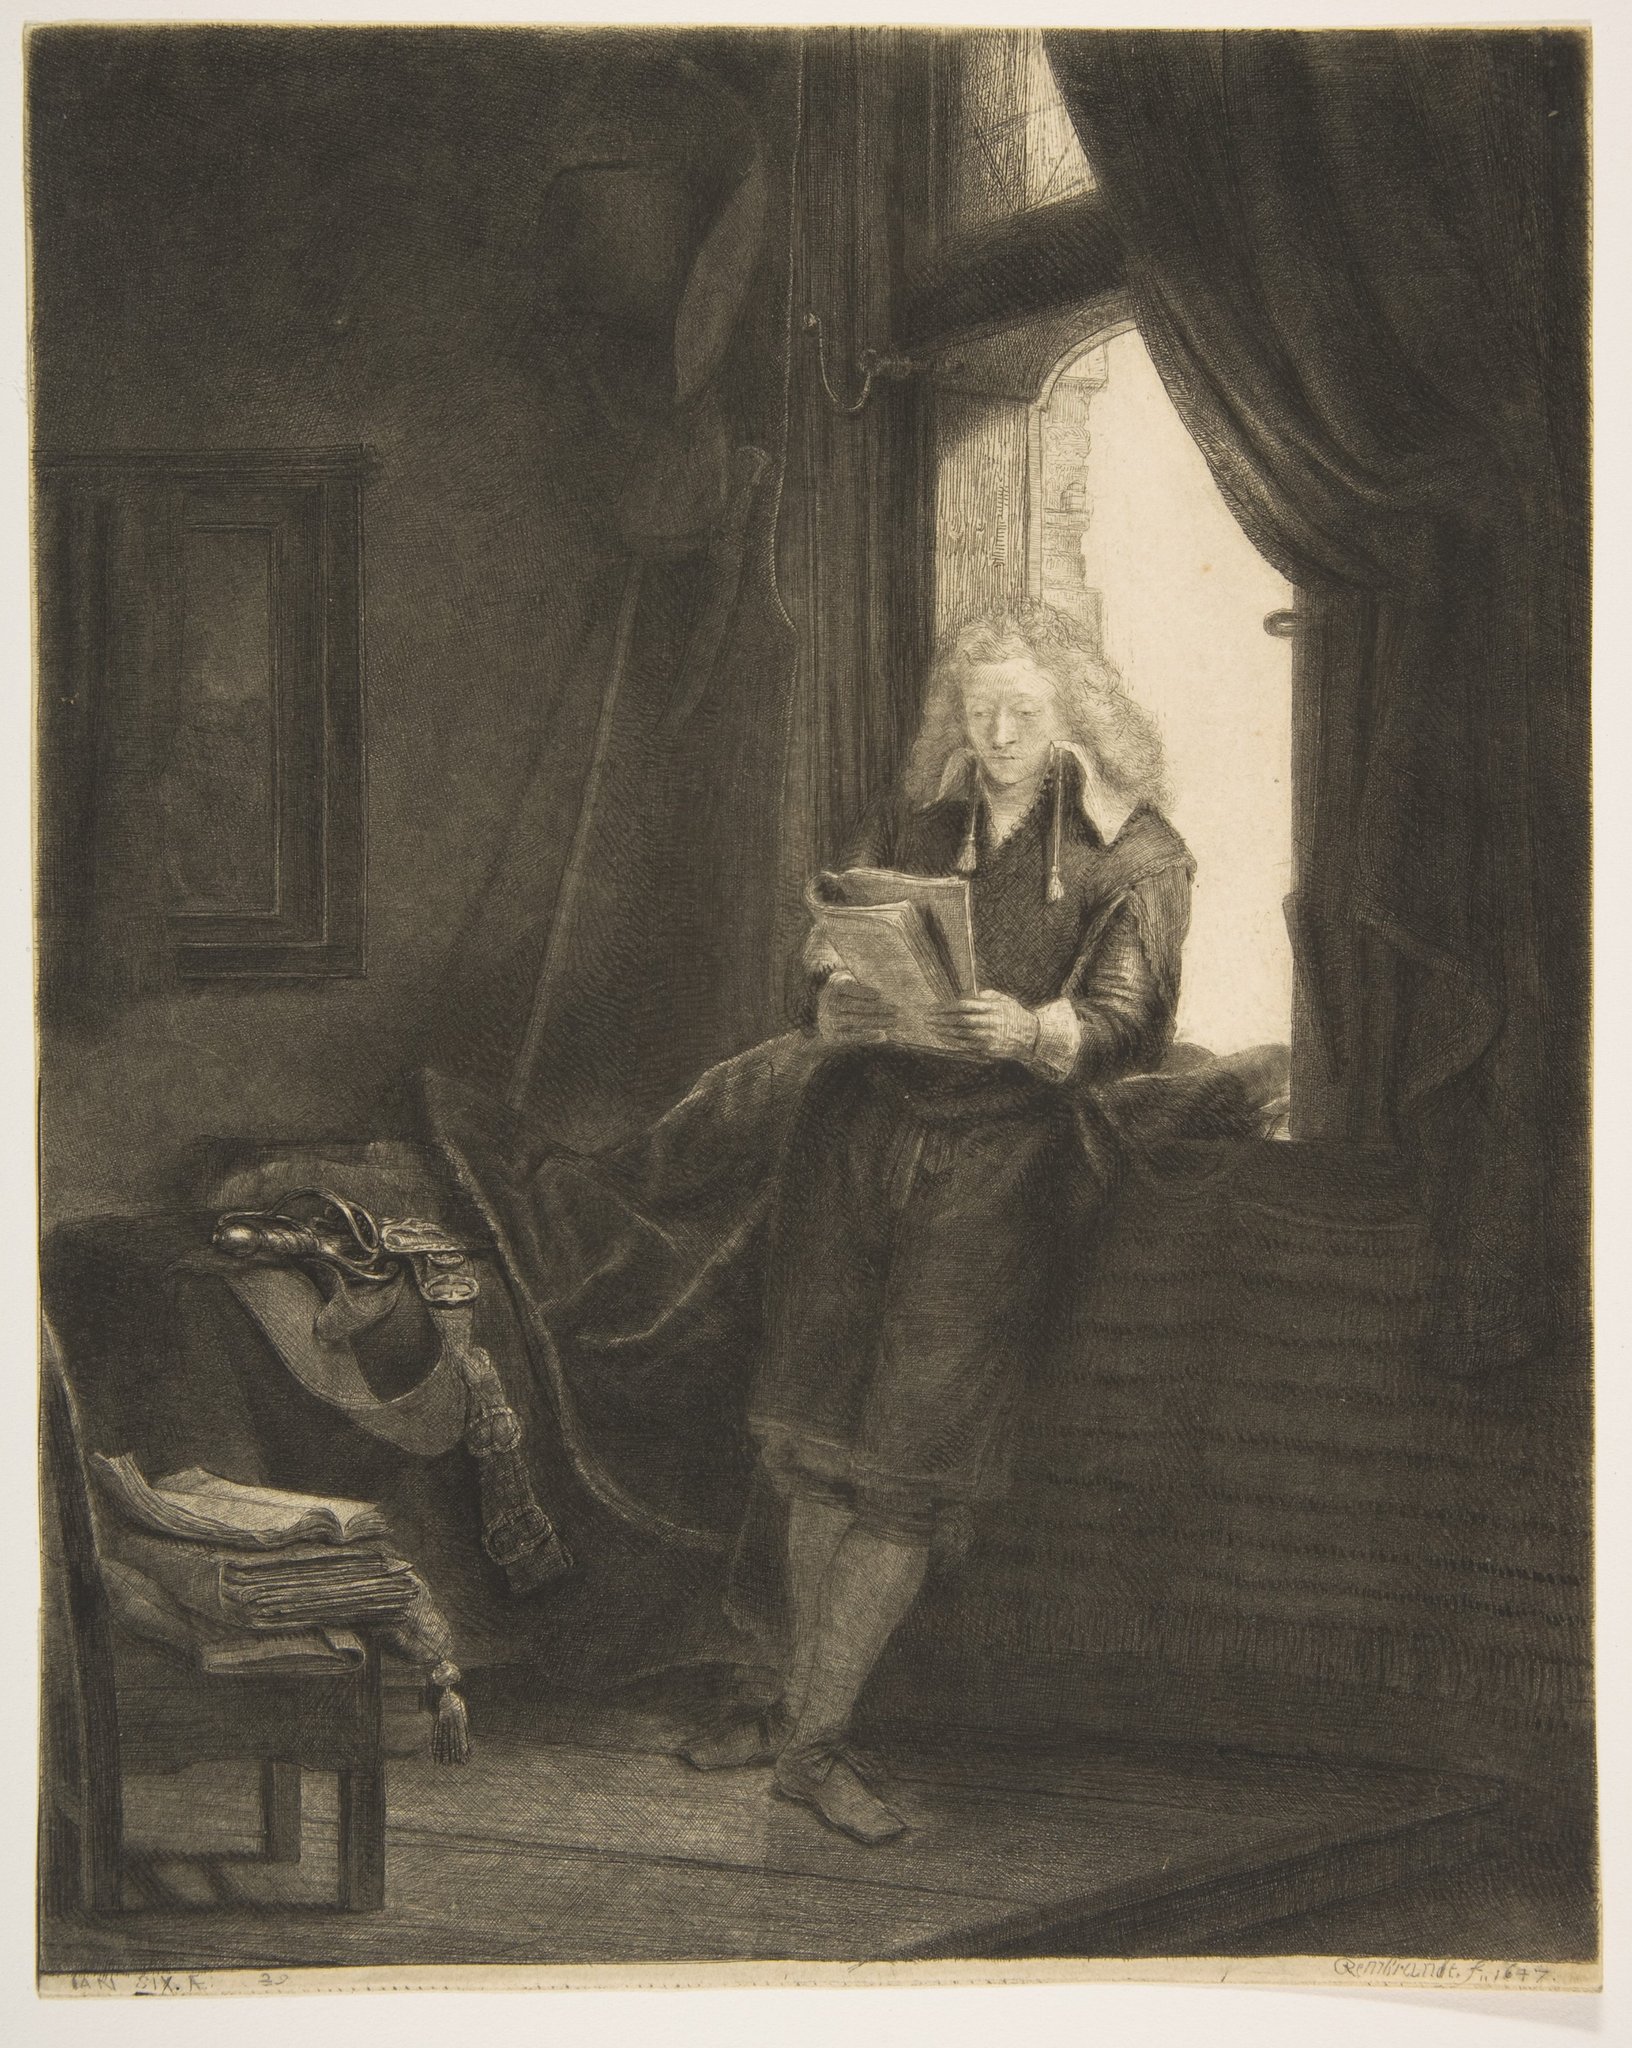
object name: print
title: Jan Six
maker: rembrandt van rijn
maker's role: artist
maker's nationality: dutch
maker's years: 1606-1669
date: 1647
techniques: drypoint, engraving, etching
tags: books,men,portraits,reading